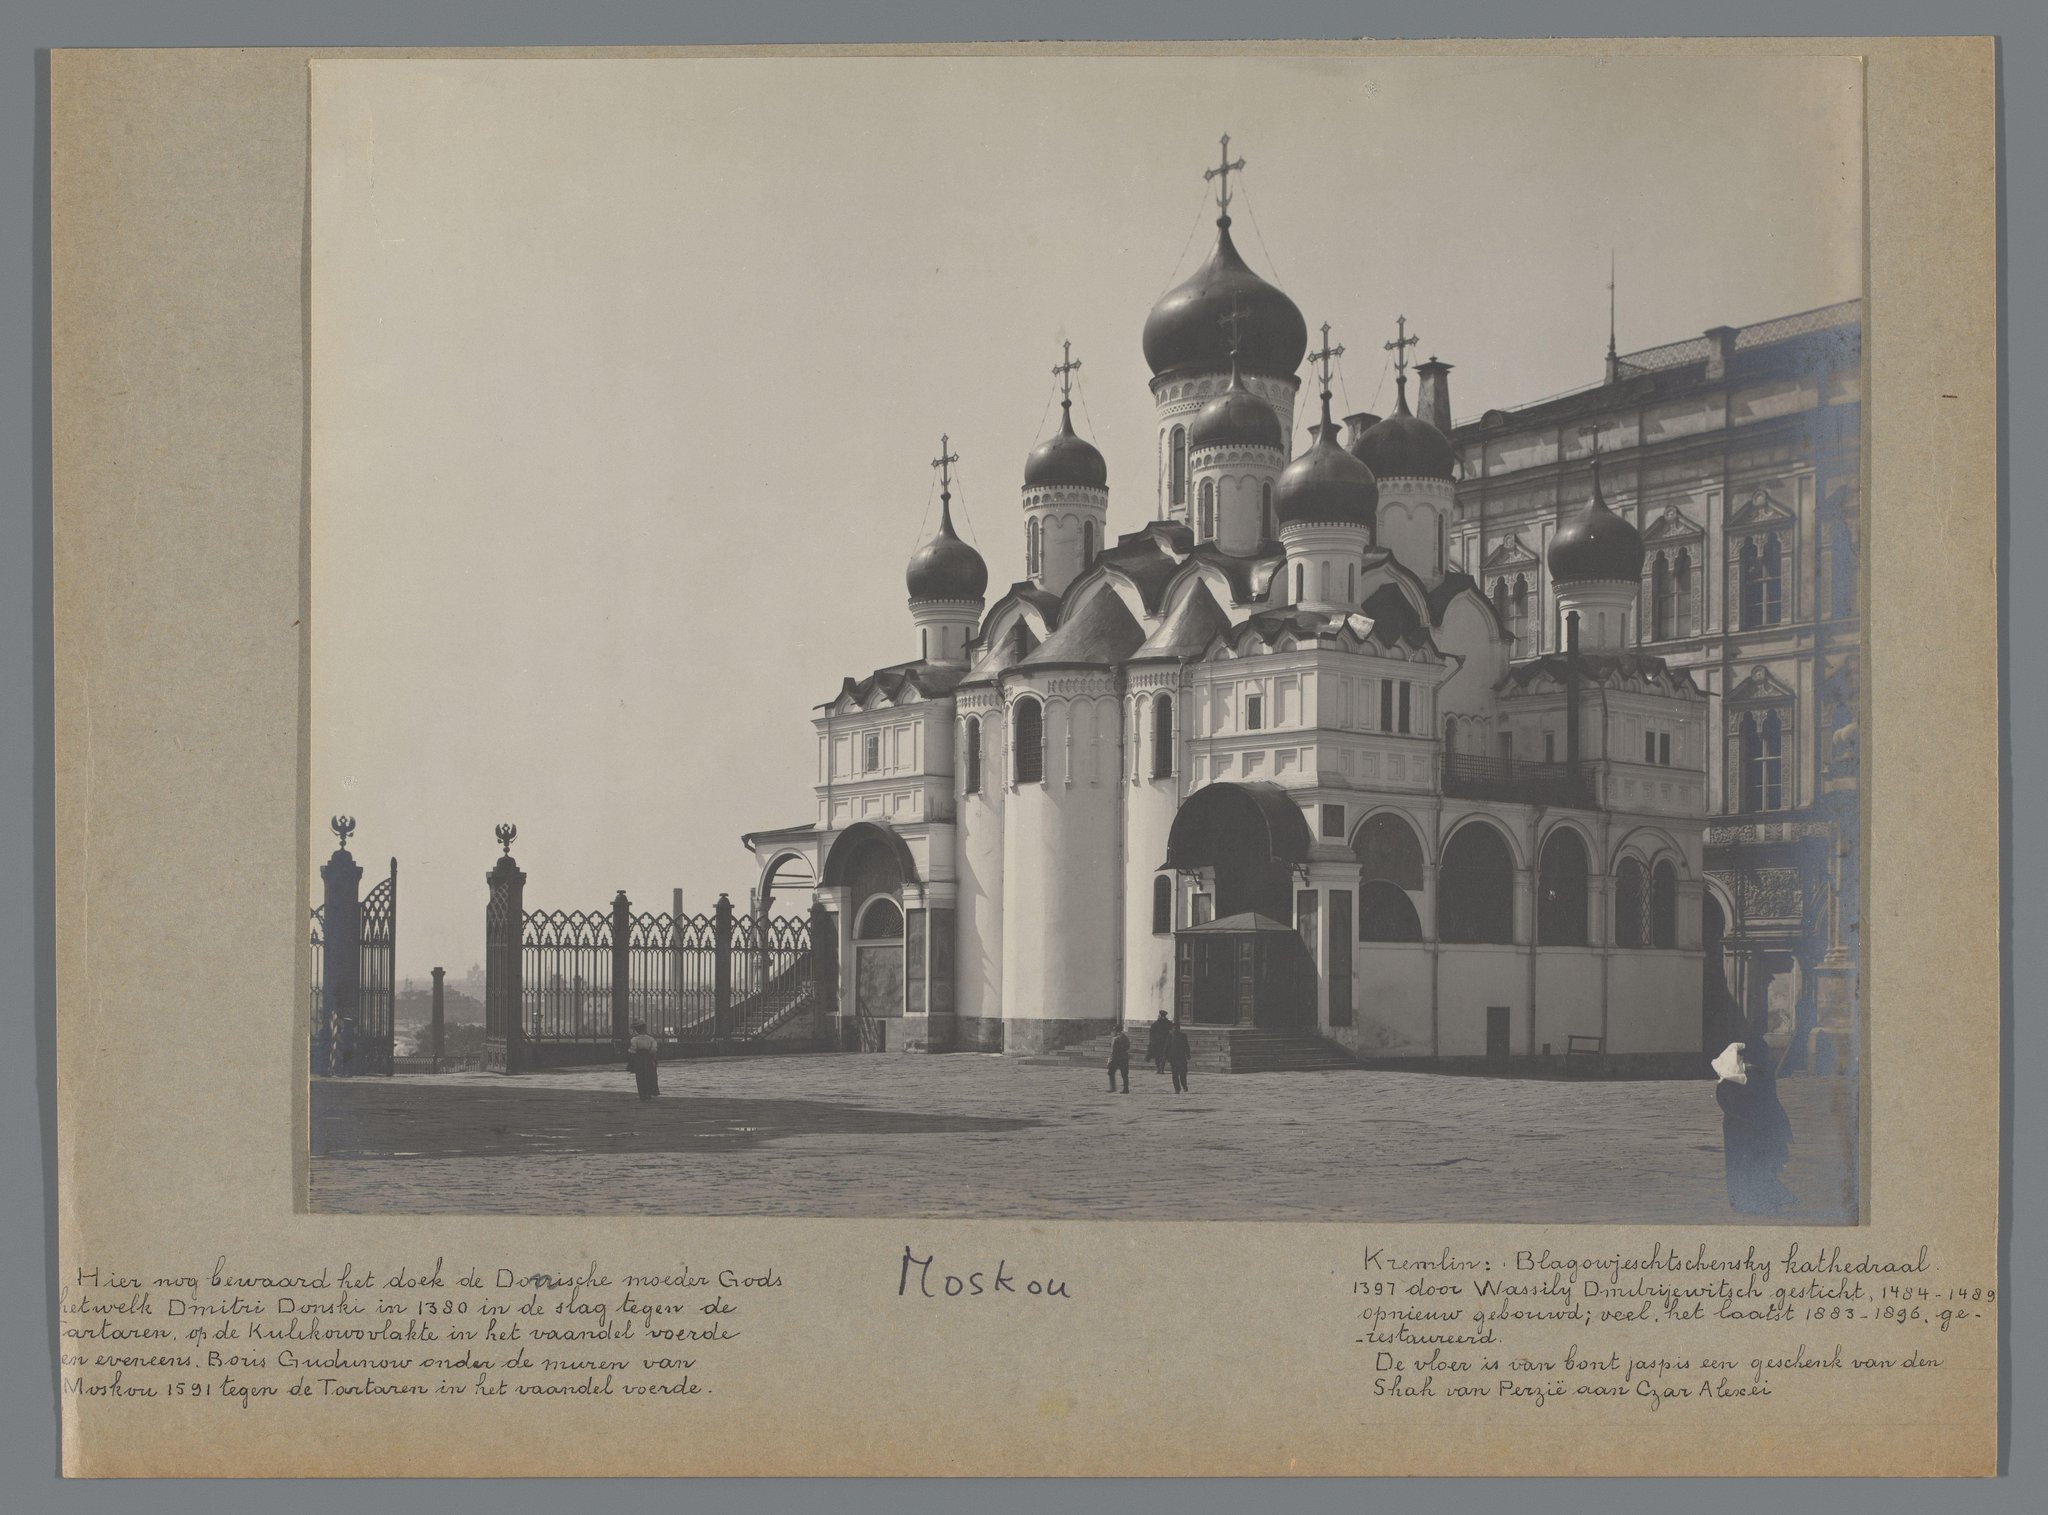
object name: photograph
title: Moskou. Kremlin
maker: Anonymous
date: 1880-1930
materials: photographic support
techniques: gelatin silver print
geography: russia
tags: kremlin